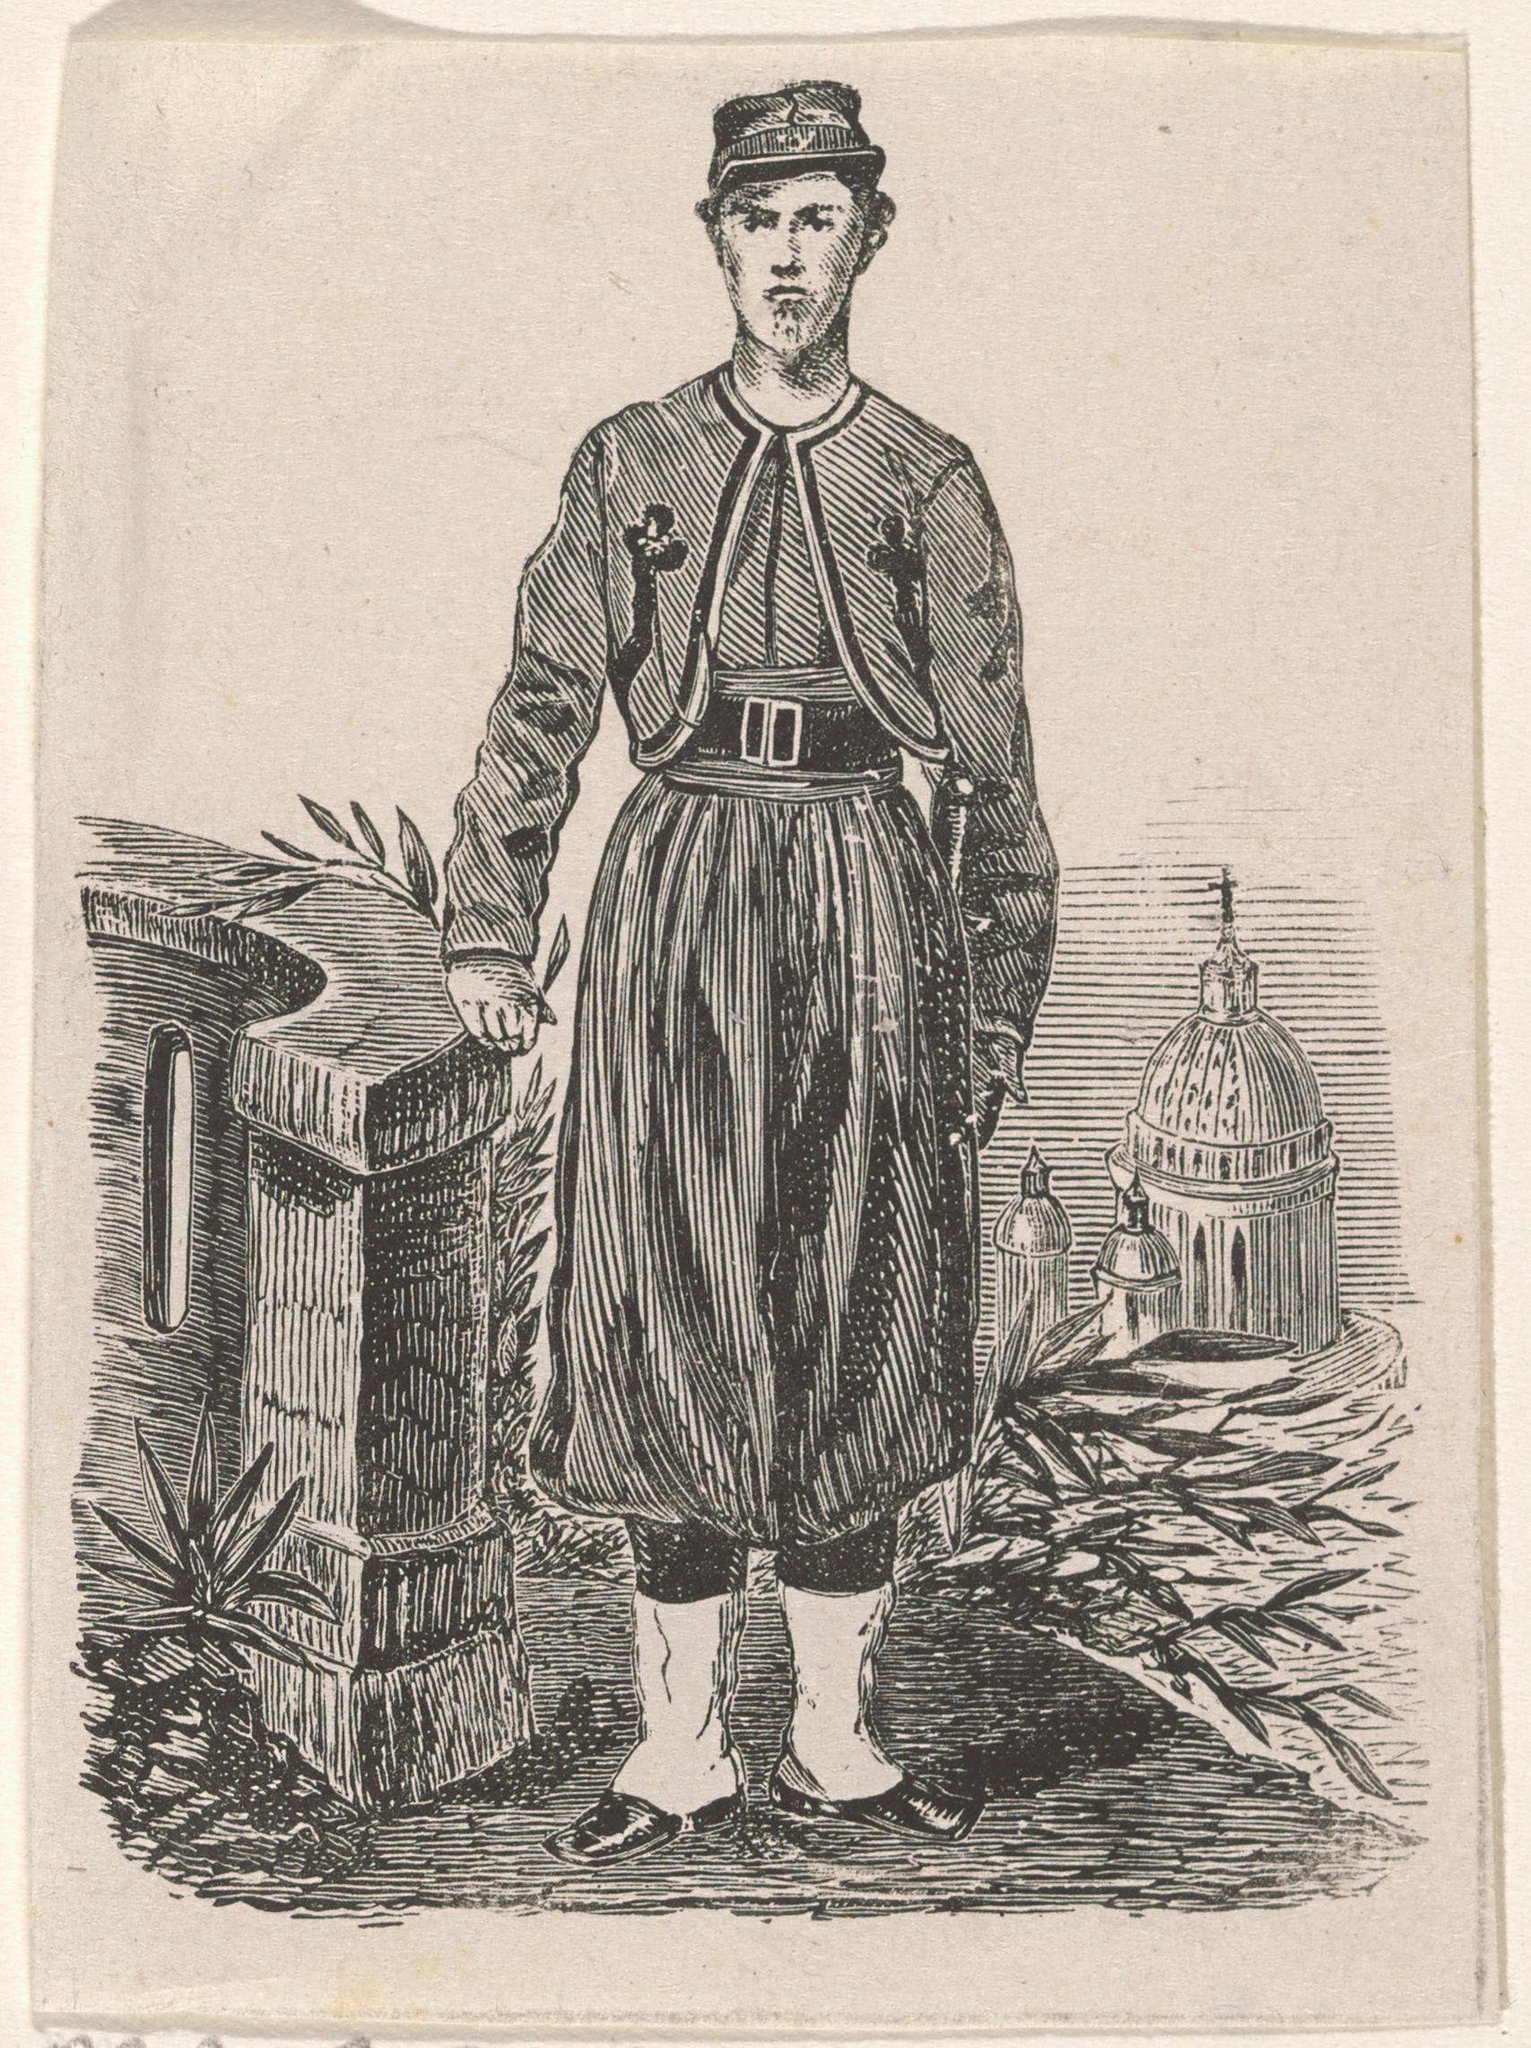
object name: print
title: Staande man met op de achtergrond een koepelkerk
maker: isaac weissenbruch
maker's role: print maker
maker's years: 1826-1912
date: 1836-1912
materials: paper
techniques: engraving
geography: netherlands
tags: church (exterior), adult man (+ standing)